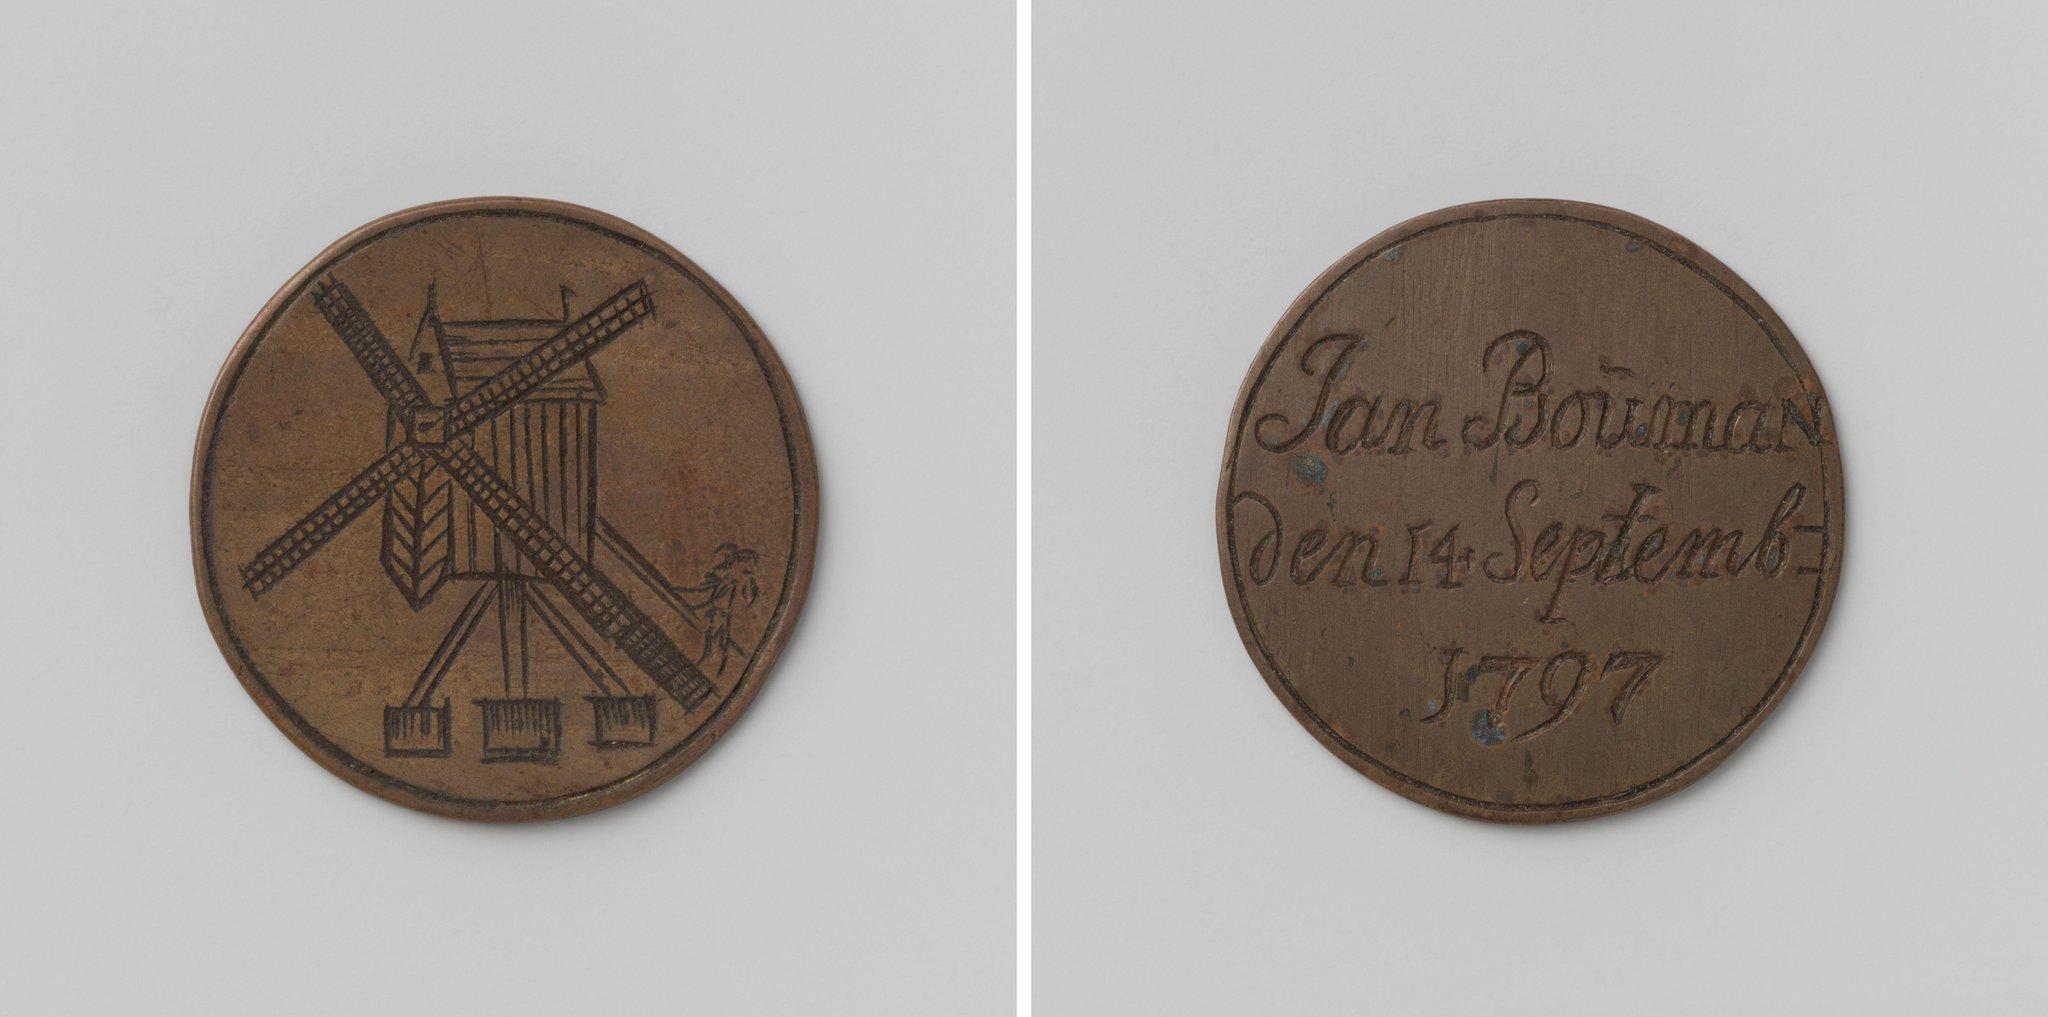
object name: medal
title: Korenmolenaarsgilde van Amsterdam, gildepenning van Jan Bouman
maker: Anonymous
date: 1797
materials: brass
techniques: engraving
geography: amsterdam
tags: publisher, jan bouman, amsterdam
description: Messing penning. Voorzijde: korenmolen; rechts molenaar staande bij trap. Keerzijde: opschrift